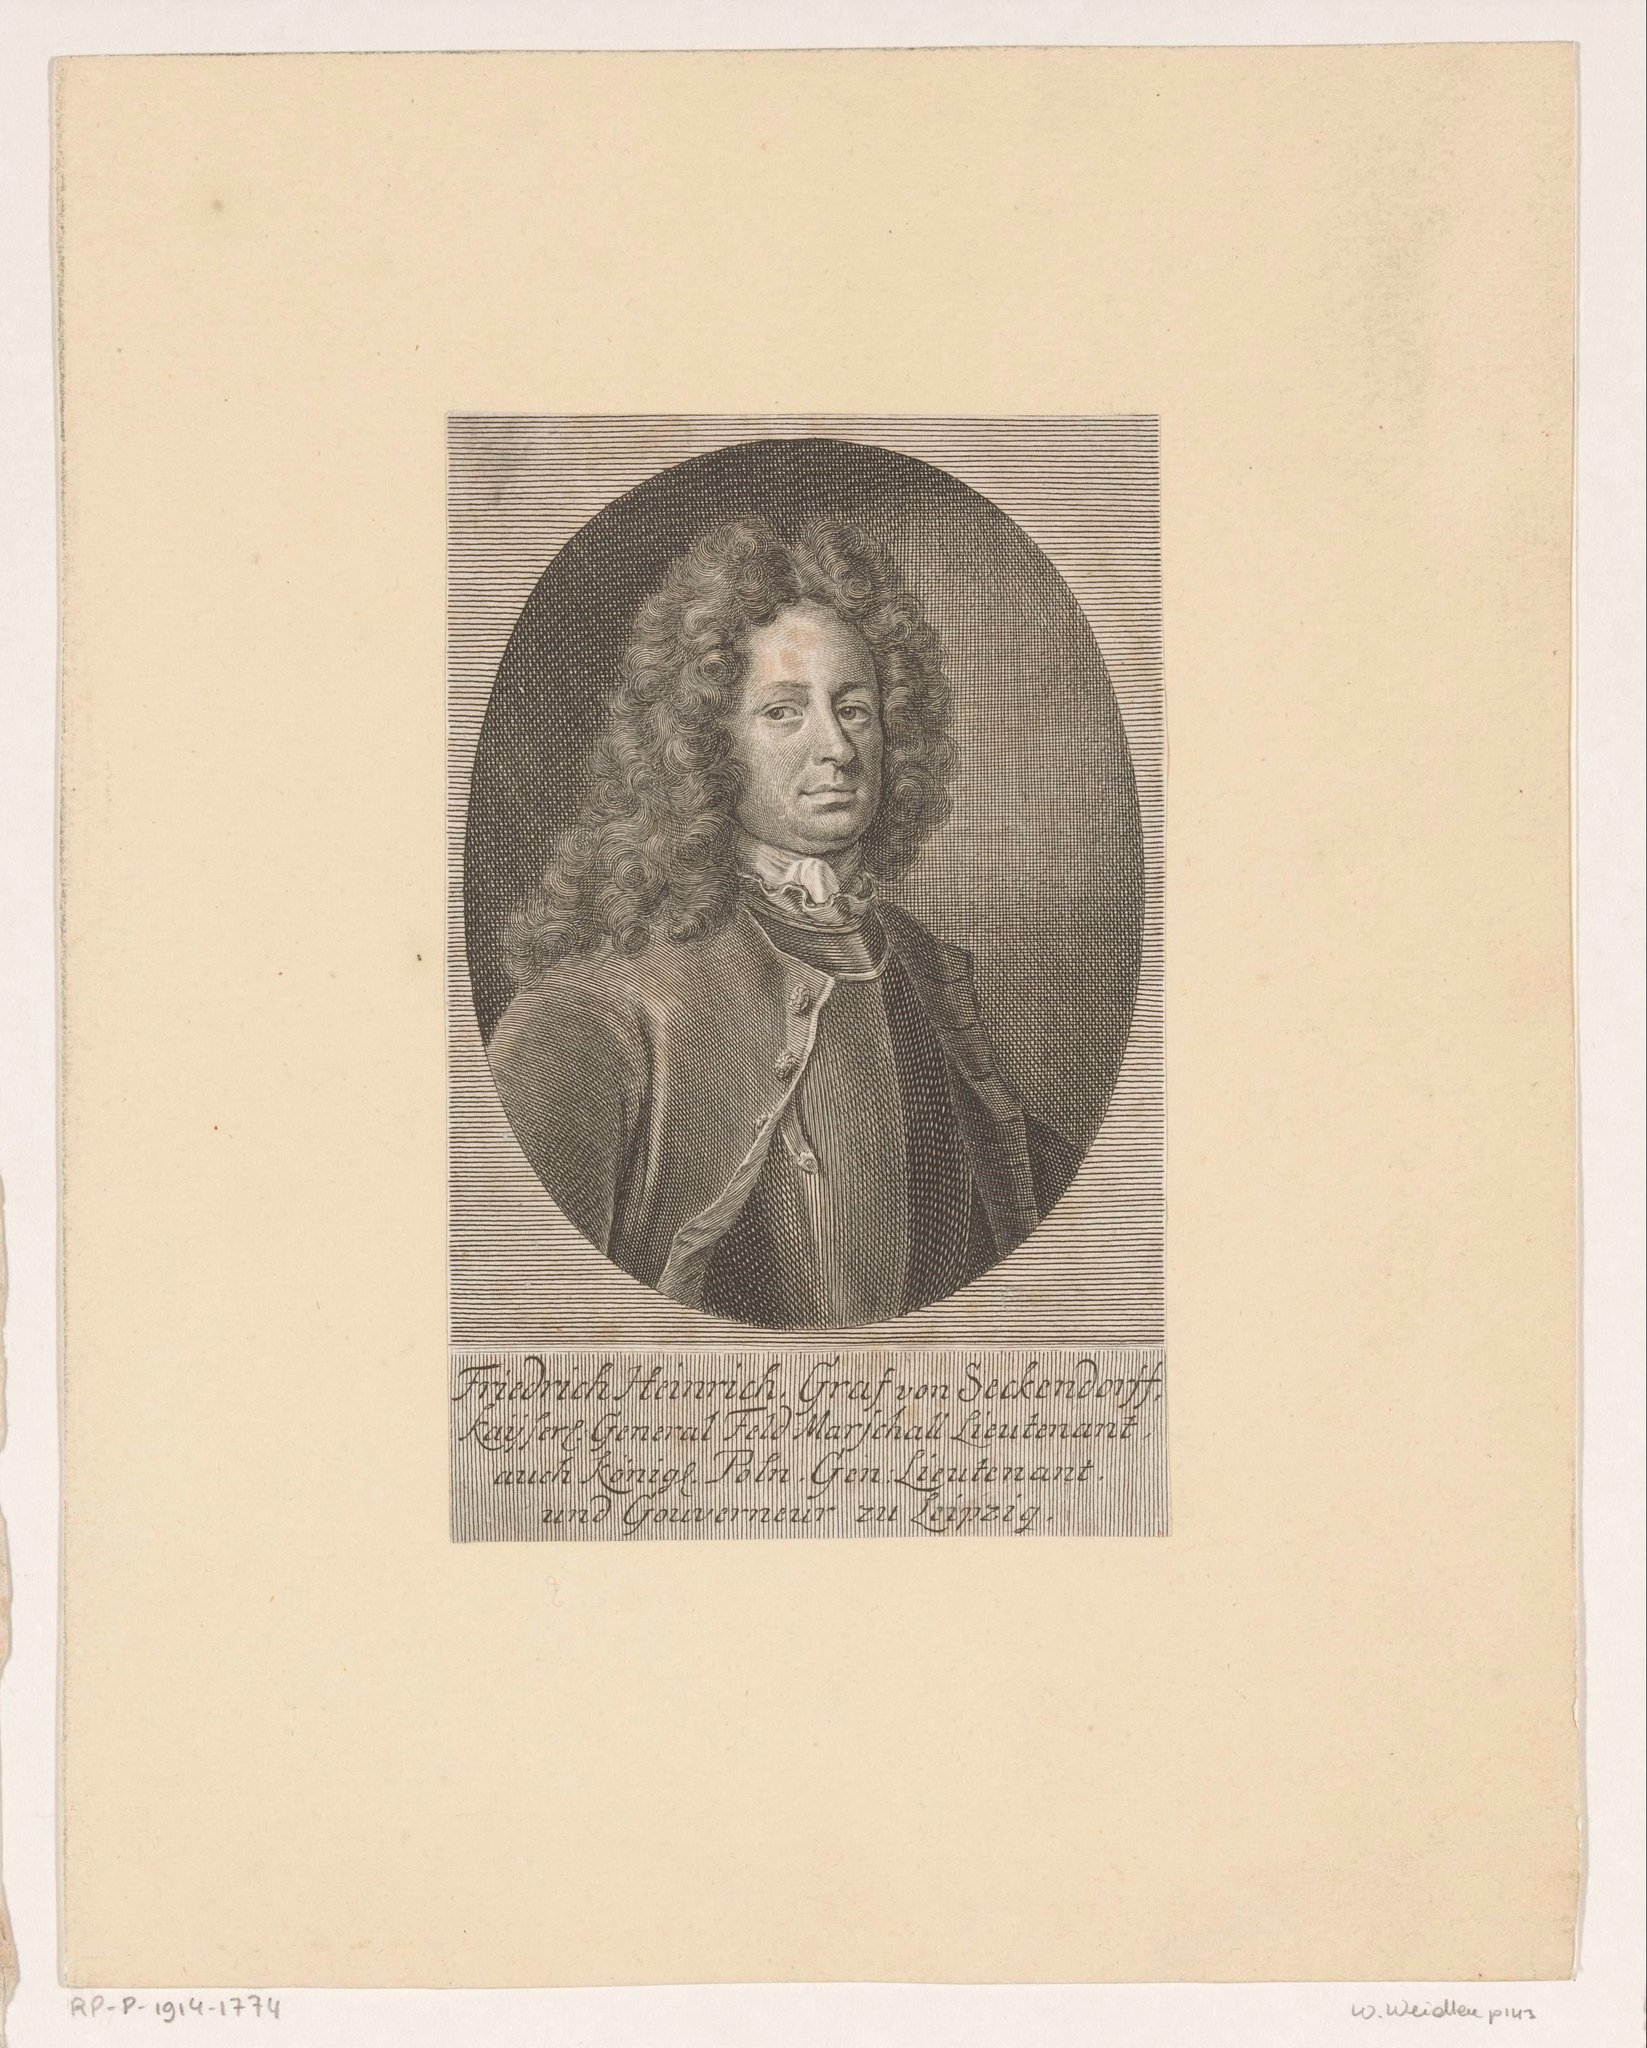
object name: print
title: Portret van Friedrich Heinrich, Reichsgraf von Seckendorf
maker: martin bernigeroth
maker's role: print maker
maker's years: 1670-1733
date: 1722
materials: paper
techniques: engraving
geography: leipzig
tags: historical persons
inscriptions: collector's mark: Lugt 2228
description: Prent ook gebruikt in: Die Europäische Fama, Welche den gegenwärtigen Zustand der vornehmsten Höfe entdecket. dl. 255. Leipzig: Gleditsch, 1722.